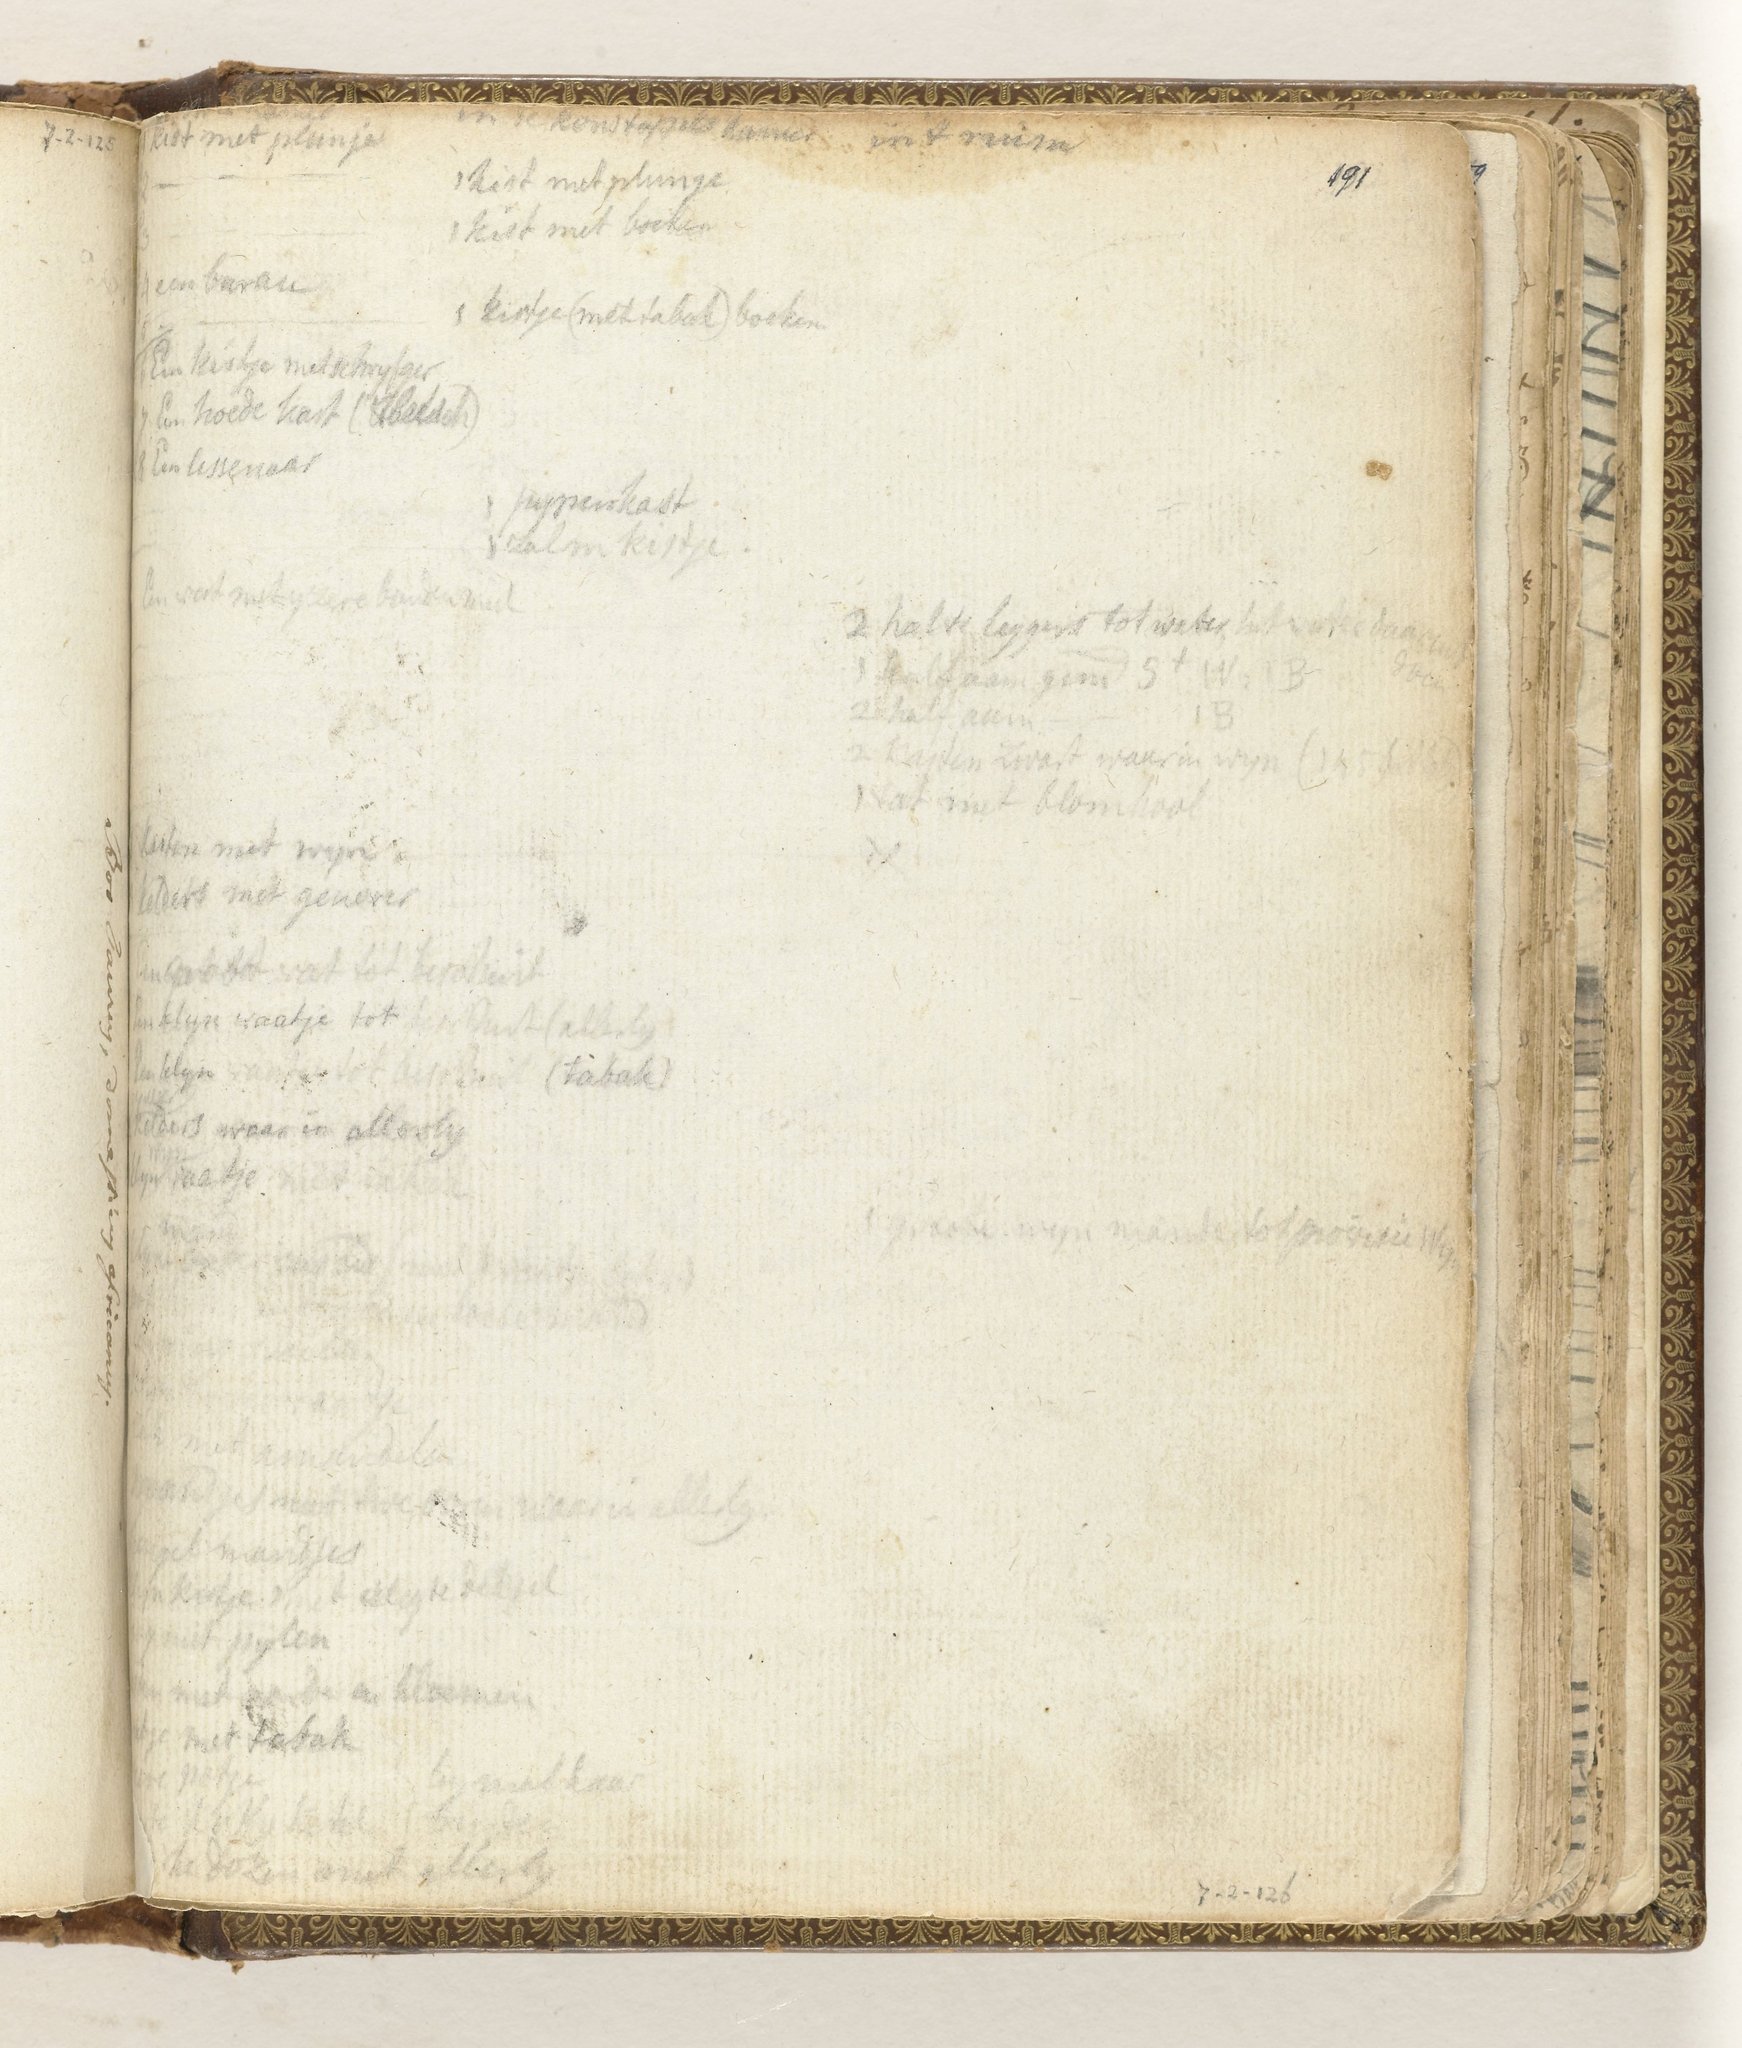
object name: drawing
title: Opzet voor een schilderij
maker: jan brandes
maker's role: draughtsman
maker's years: 1743-1808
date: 1701-1784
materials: paper, pencil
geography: jakarta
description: Schets met opschrift over de indeling en inhoud van een schilderij gegeven aan Smith en 'pader' Hooyman even na nieuwjaar 1784. Onderdeel uit het schetsboek van Jan Brandes, dl. 2 (1808), p. 192.